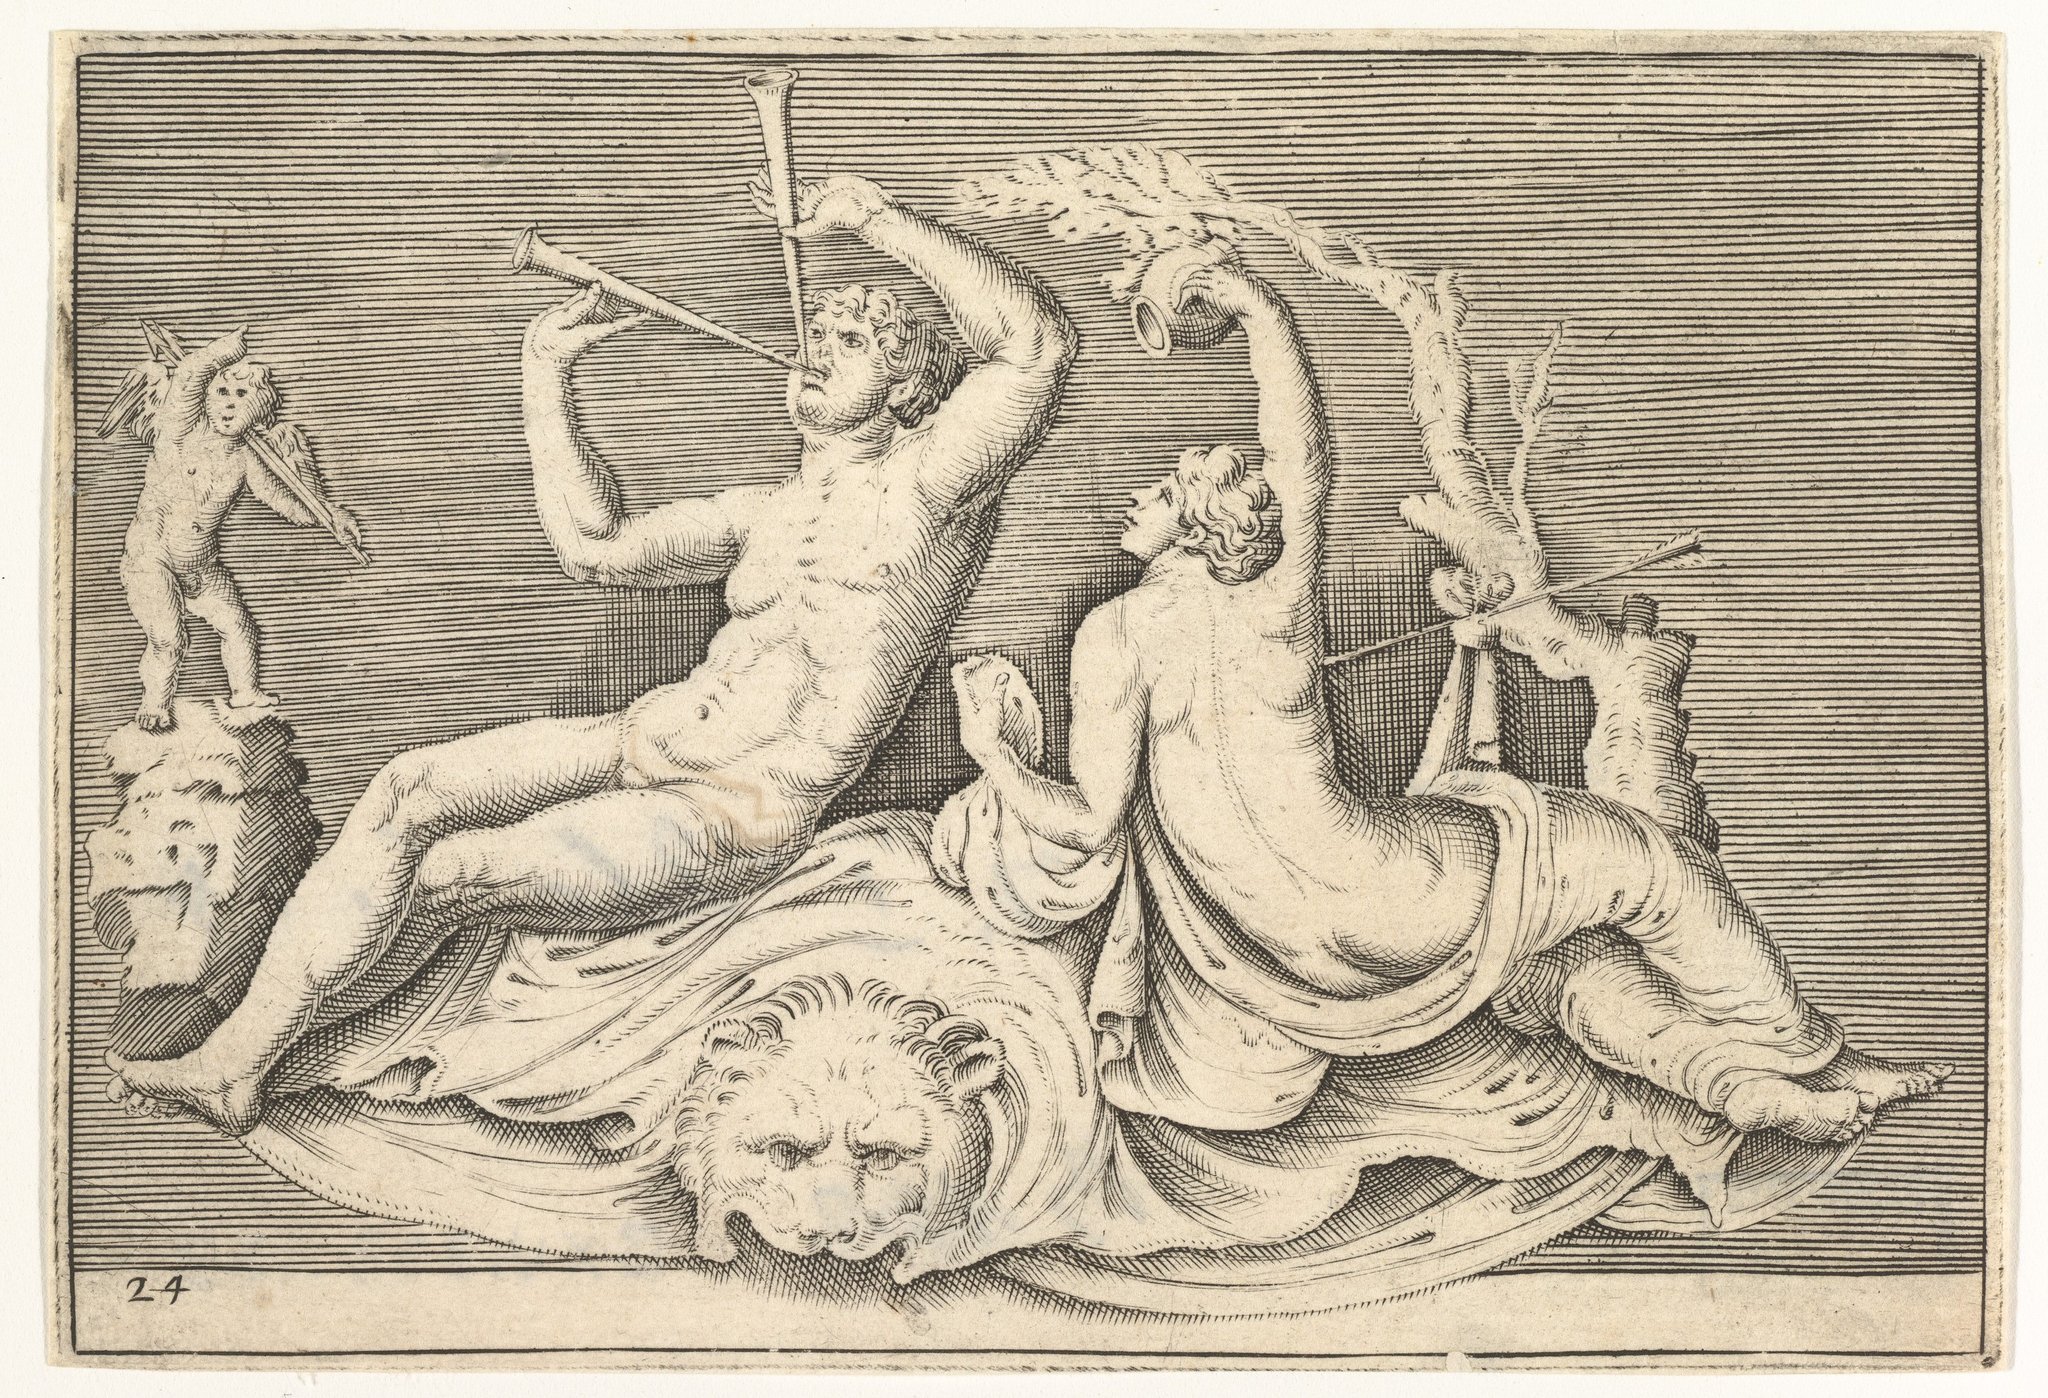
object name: print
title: Man Playing Two Flutes and Woman on Lionskin, from "Ex Antiquis Cameorum et Gemmae Delineata/ Liber Secundus/et ab Enea Vico Parmen Incis"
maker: anonymous, italian, 16th century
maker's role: artist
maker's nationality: italian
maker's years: 1500-1600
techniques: engraving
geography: rome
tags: musical instruments,male nudes,female nudes